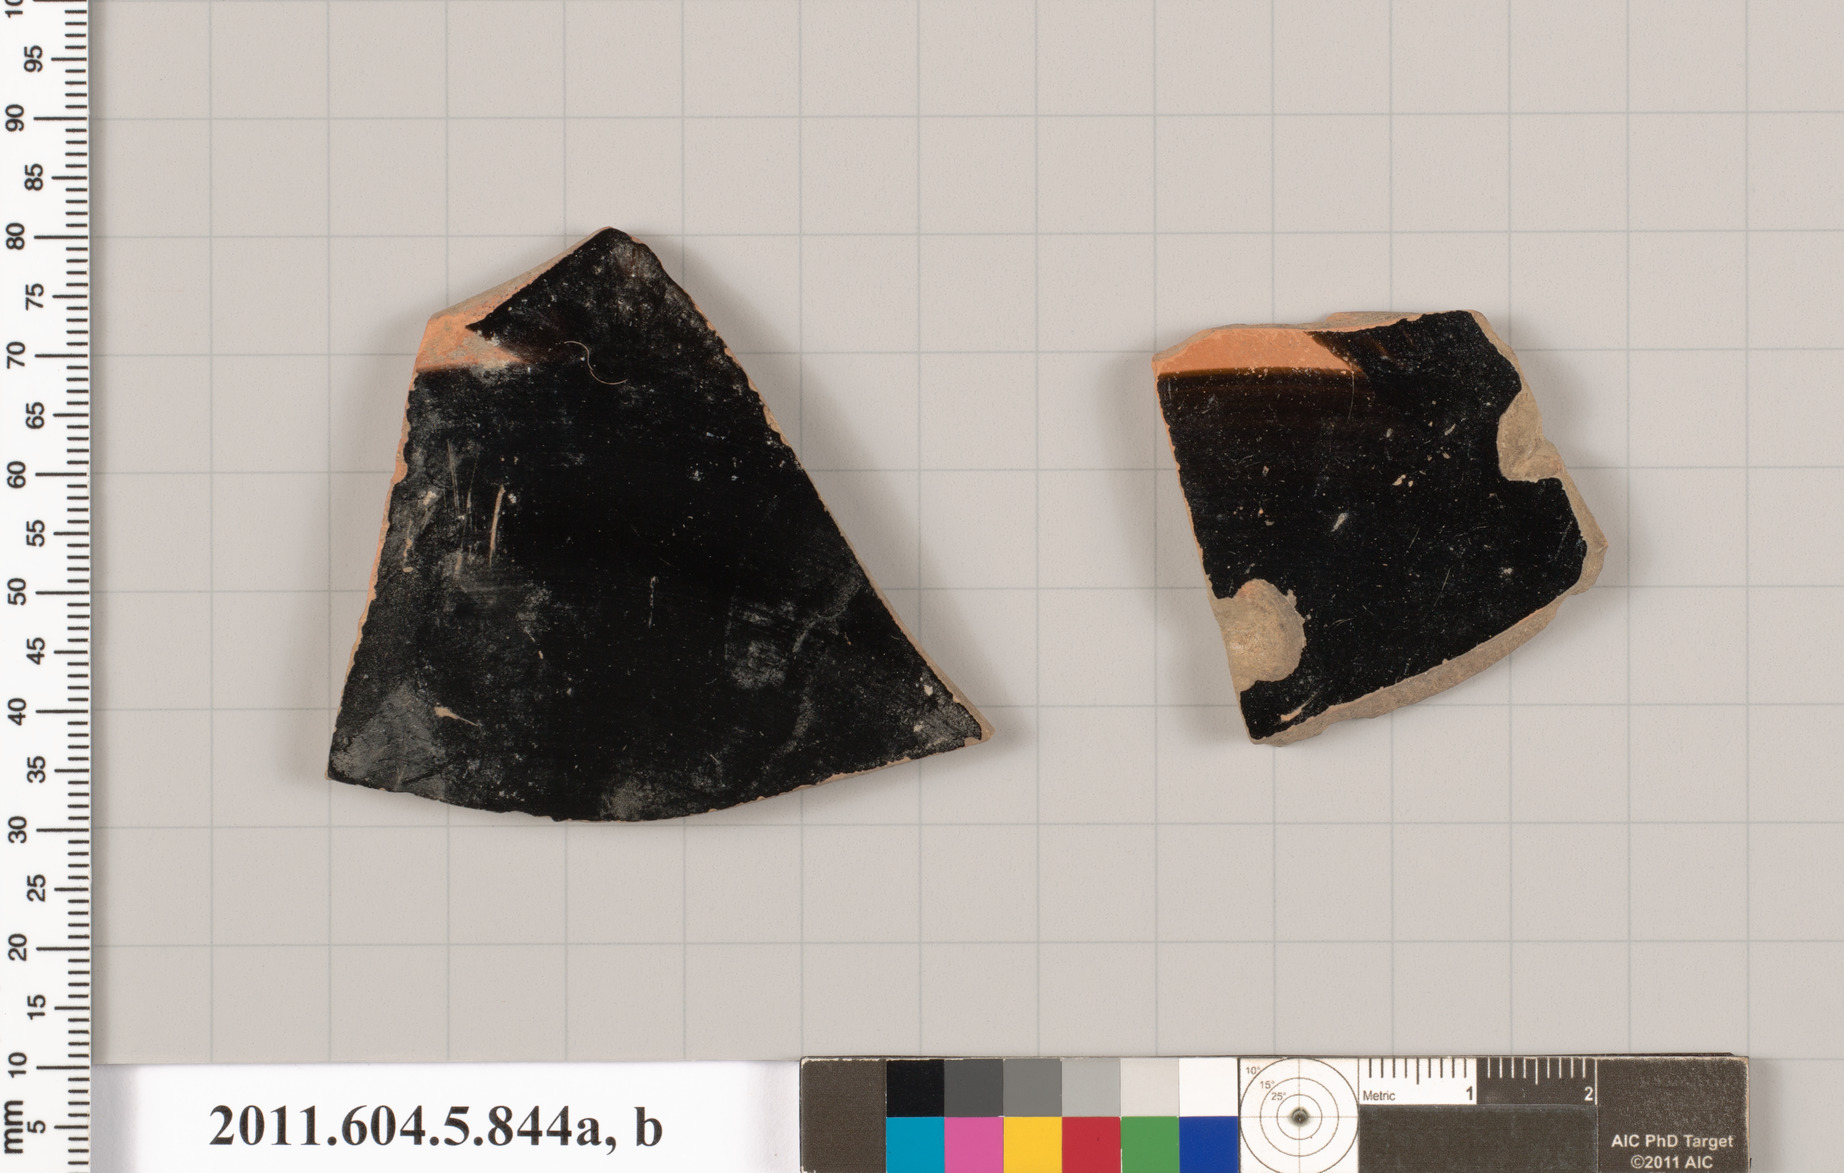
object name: kylix fragment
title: Terracotta fragments of kylikes (drinking cups)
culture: greek, attic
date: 600-401 BCE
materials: terracotta